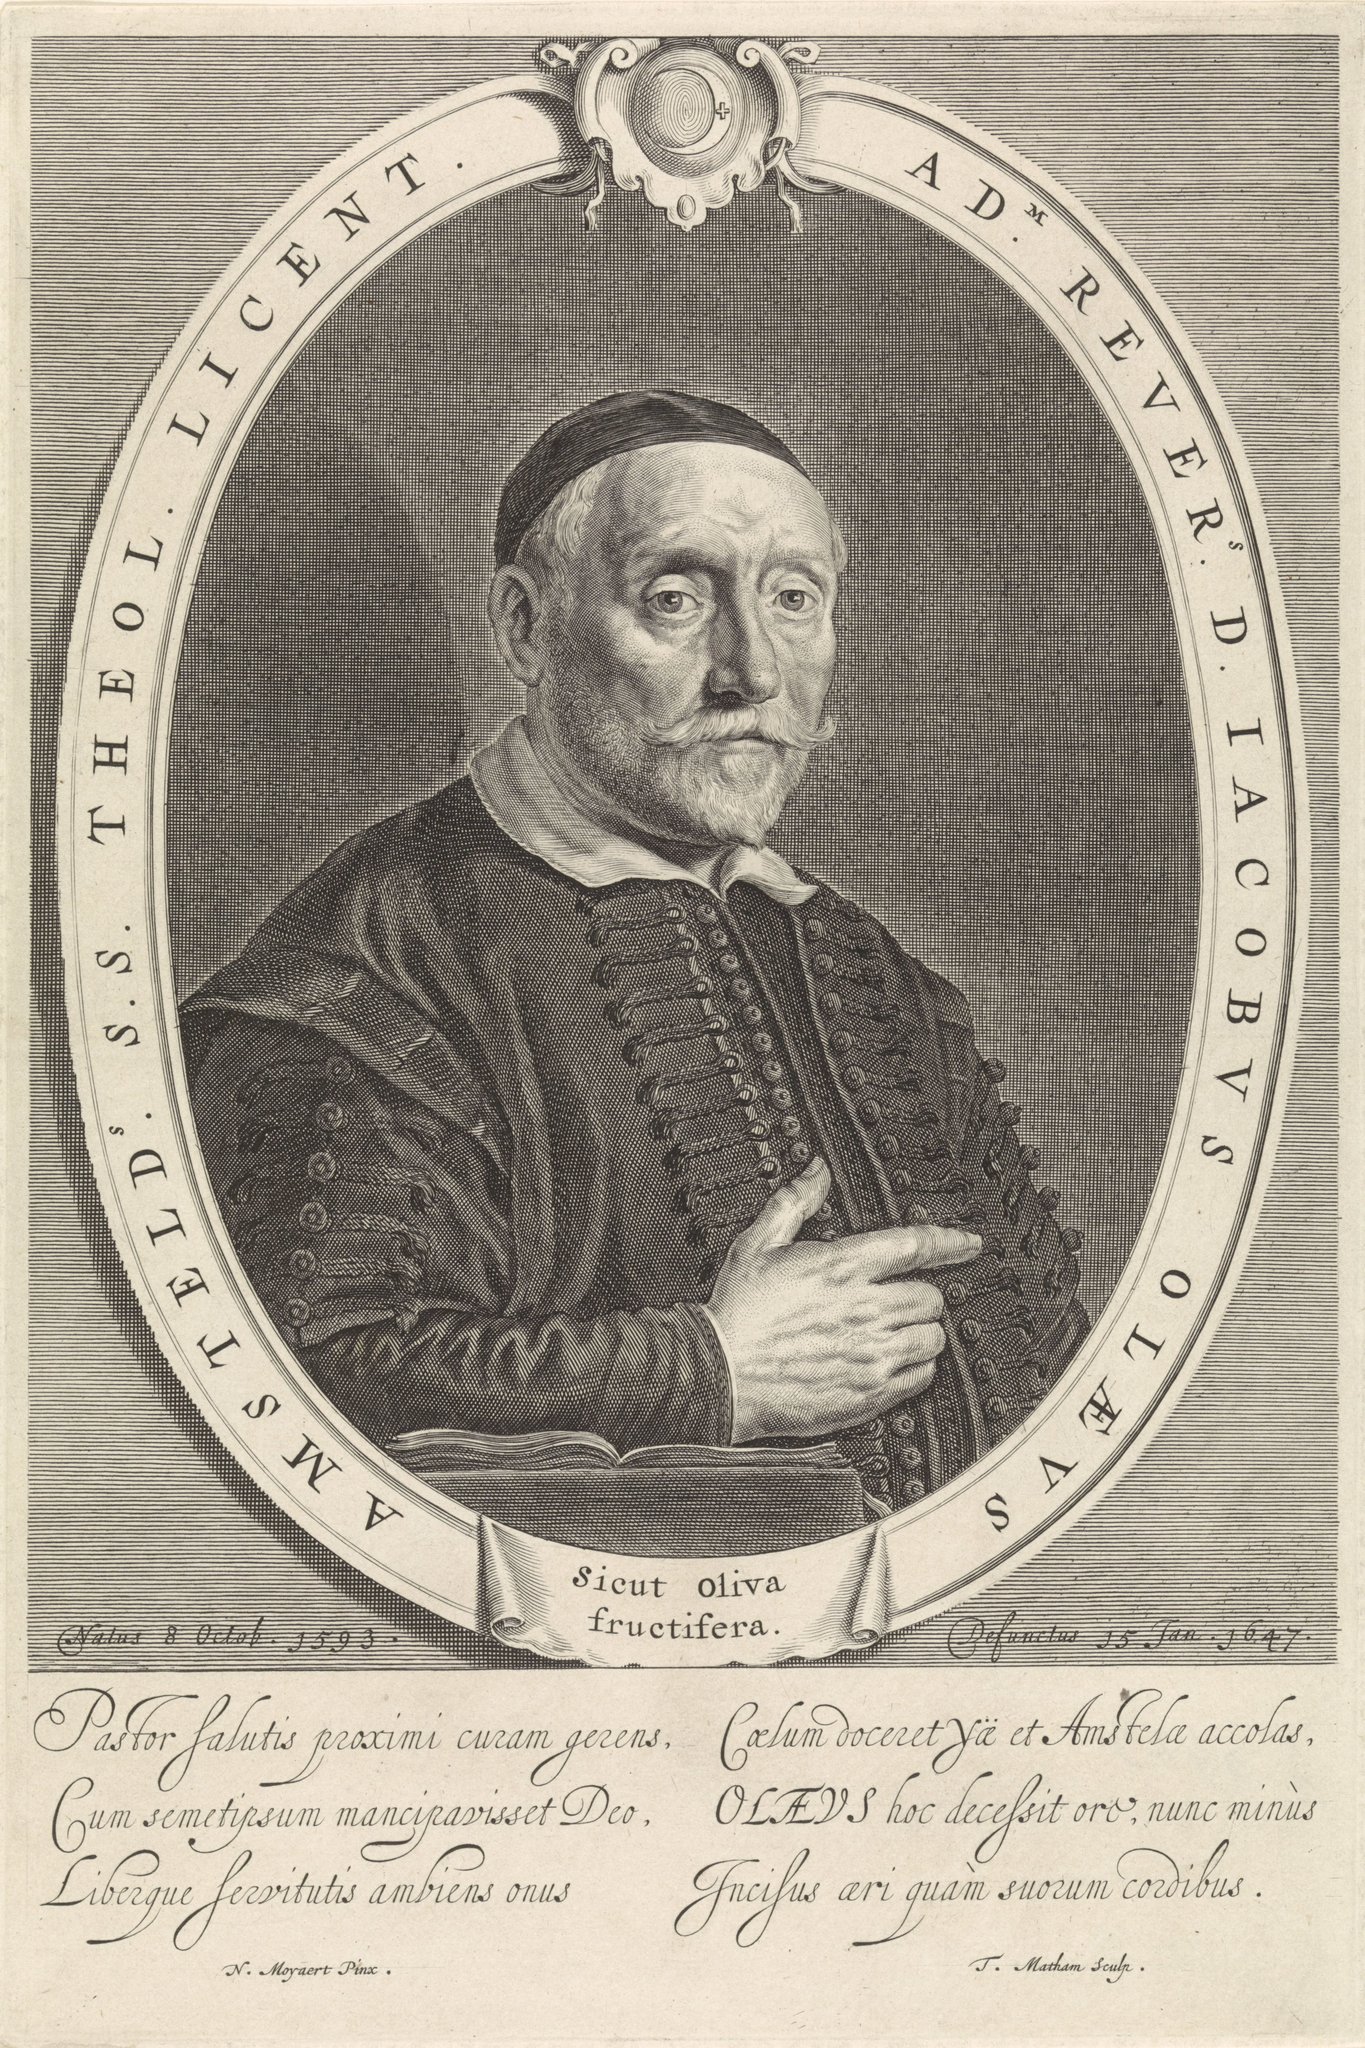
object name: print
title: Portret van Jacobus Olaeus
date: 1647-1676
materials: paper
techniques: engraving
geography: northern netherlands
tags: jacobus olaeus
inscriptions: collector's mark: Lugt 2228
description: Portret van Jacobus Olaeus, pastoor te Amsterdam.